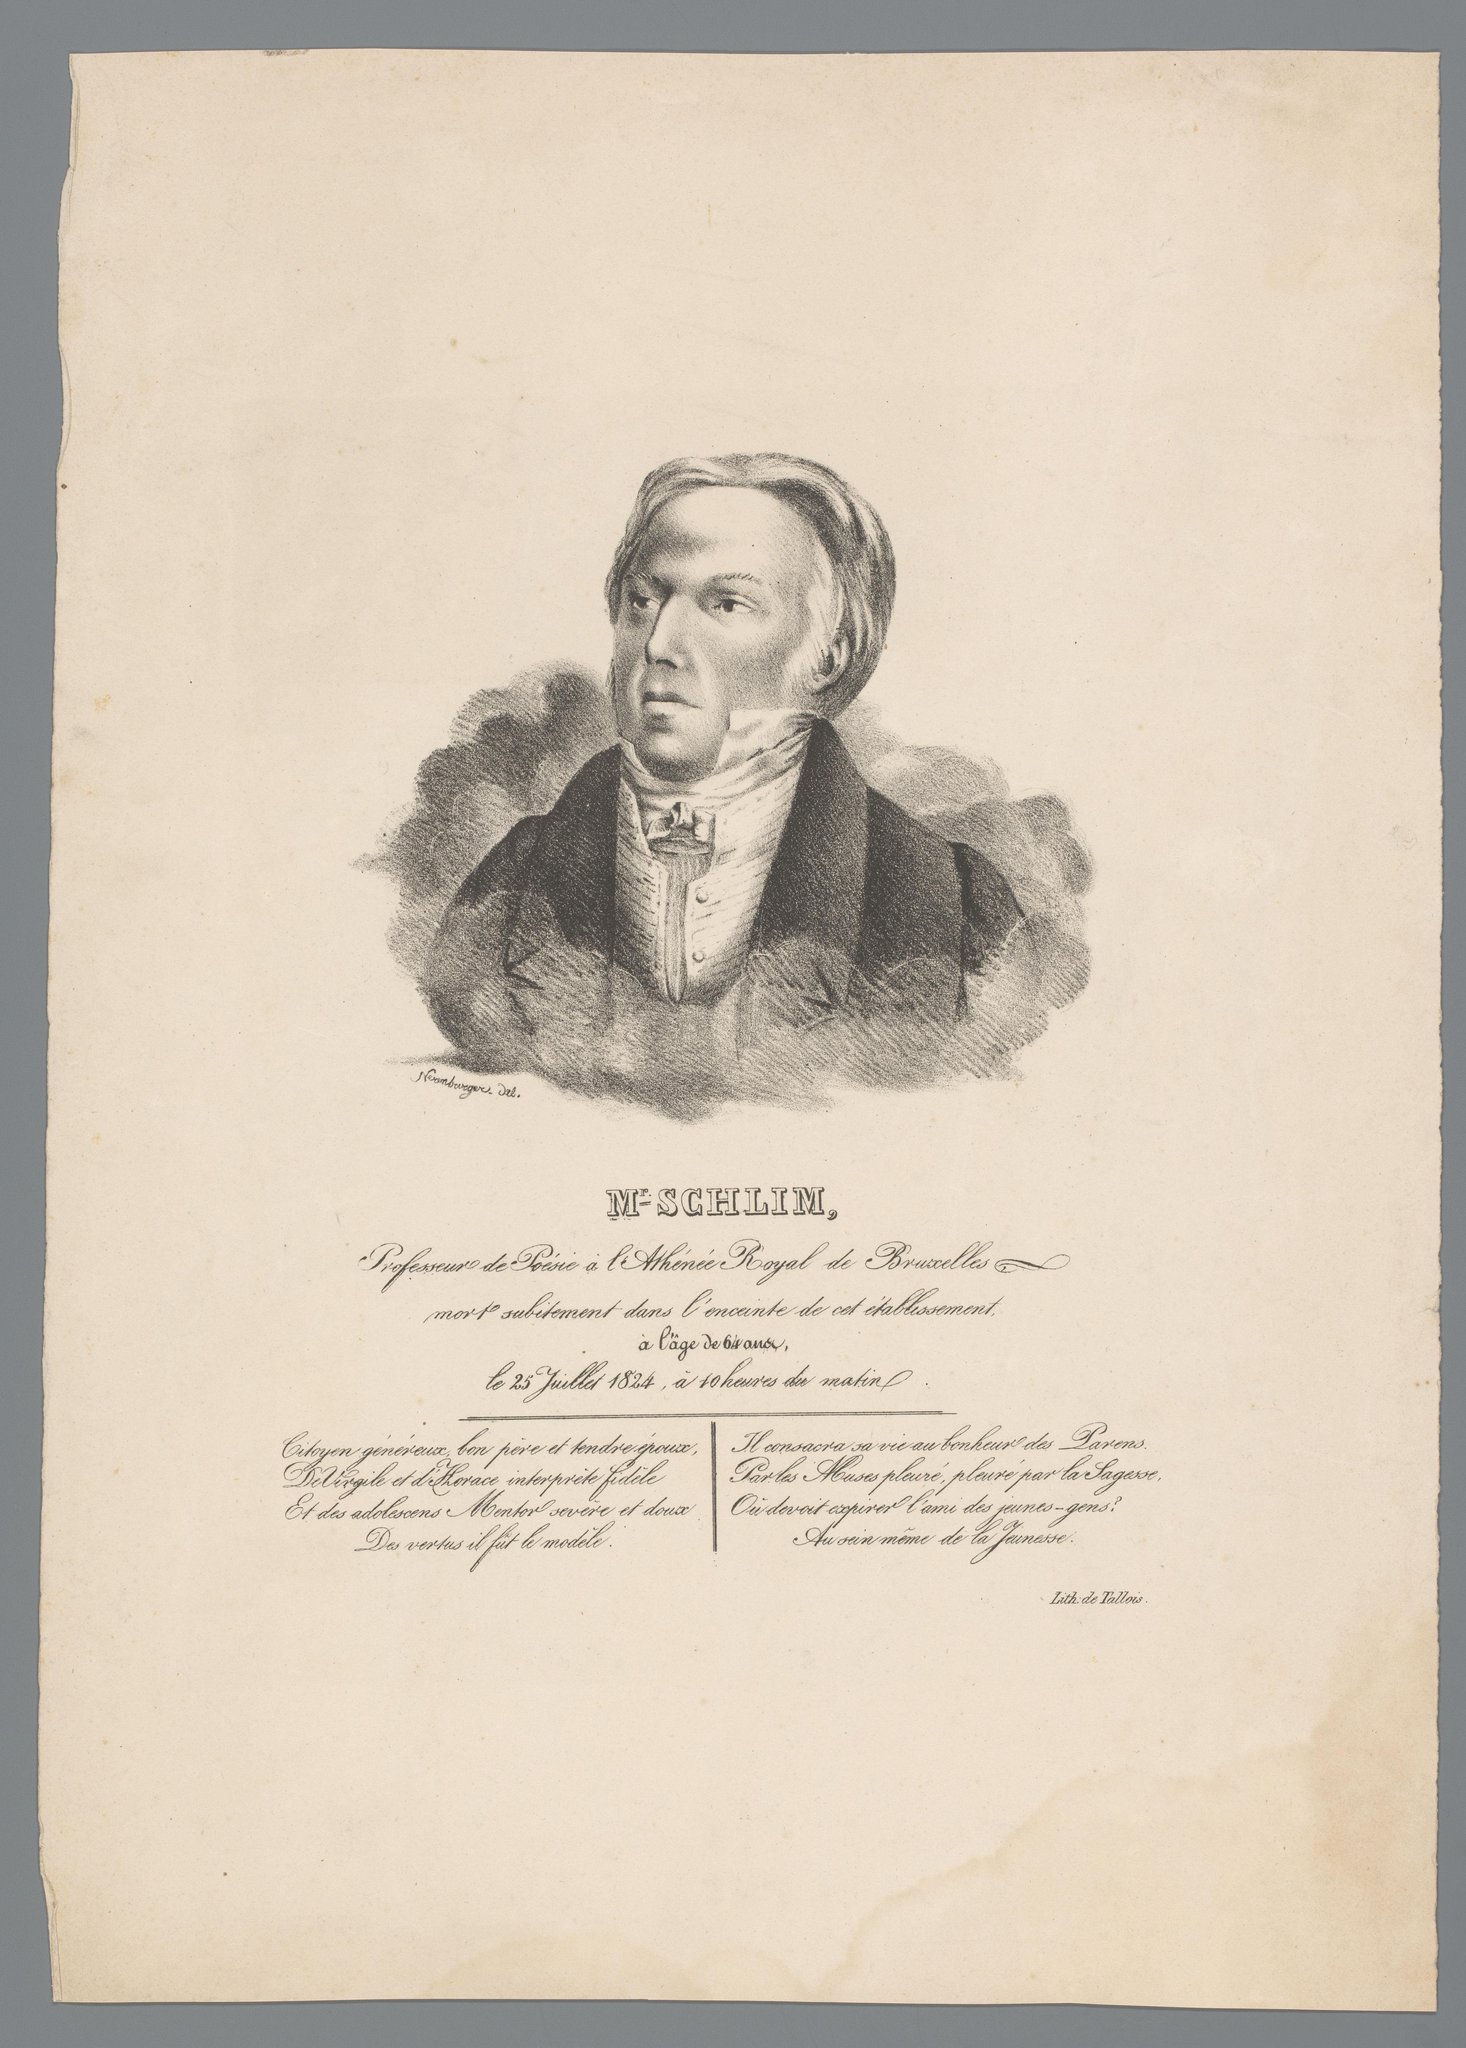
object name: print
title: Mr. Schlim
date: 1824-1875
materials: paper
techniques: lithograph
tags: adult man, historical persons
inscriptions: collector's mark: Lugt 2228